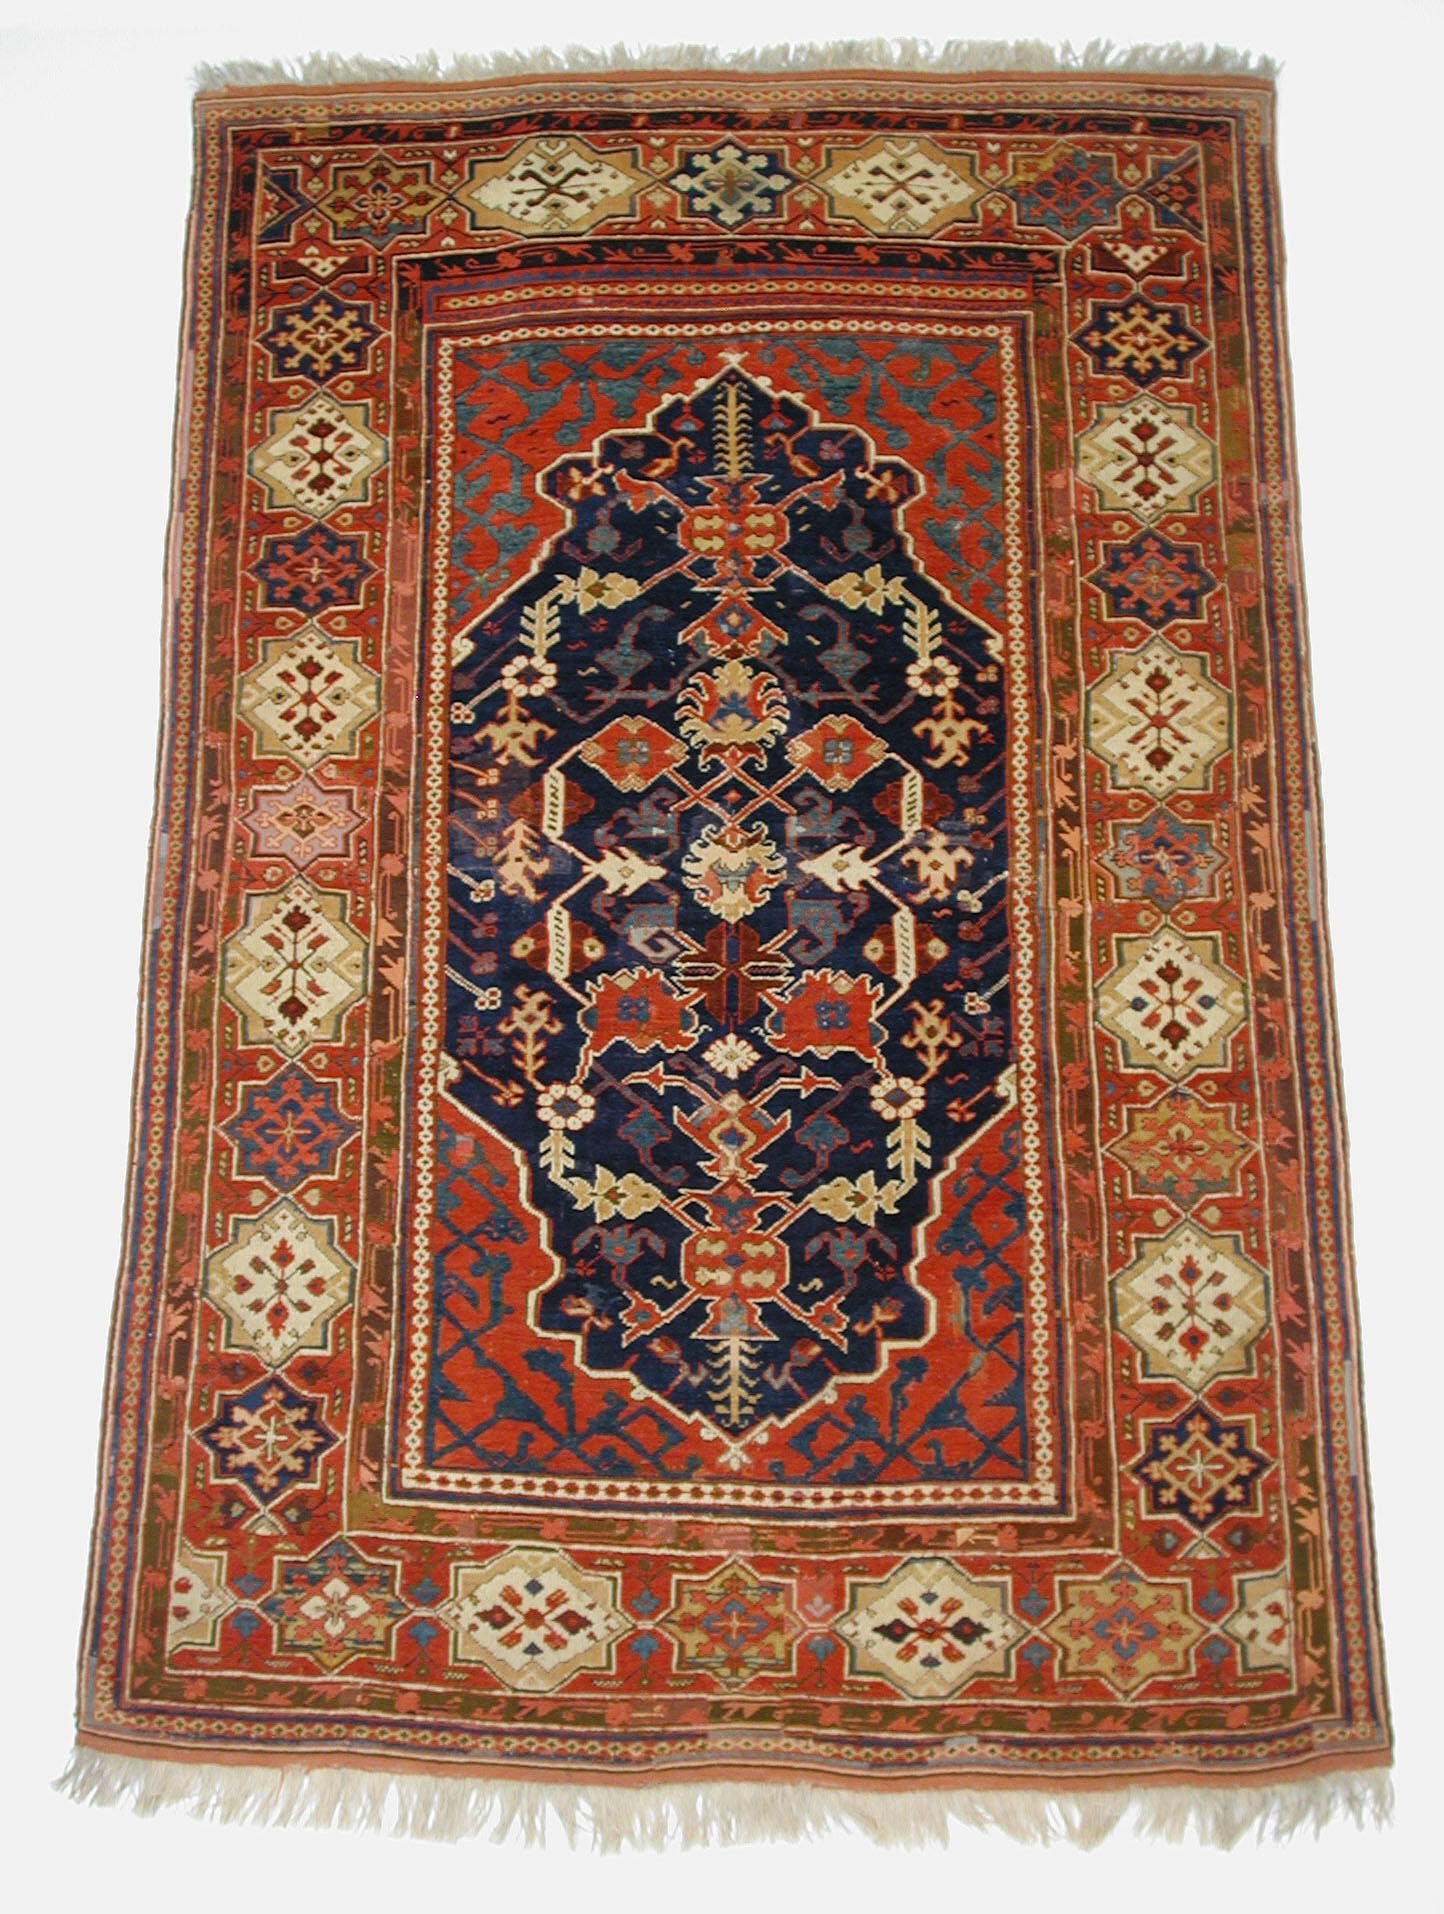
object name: carpet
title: 'Transylvanian' Carpet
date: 1601-1700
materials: wool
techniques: pile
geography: turkey